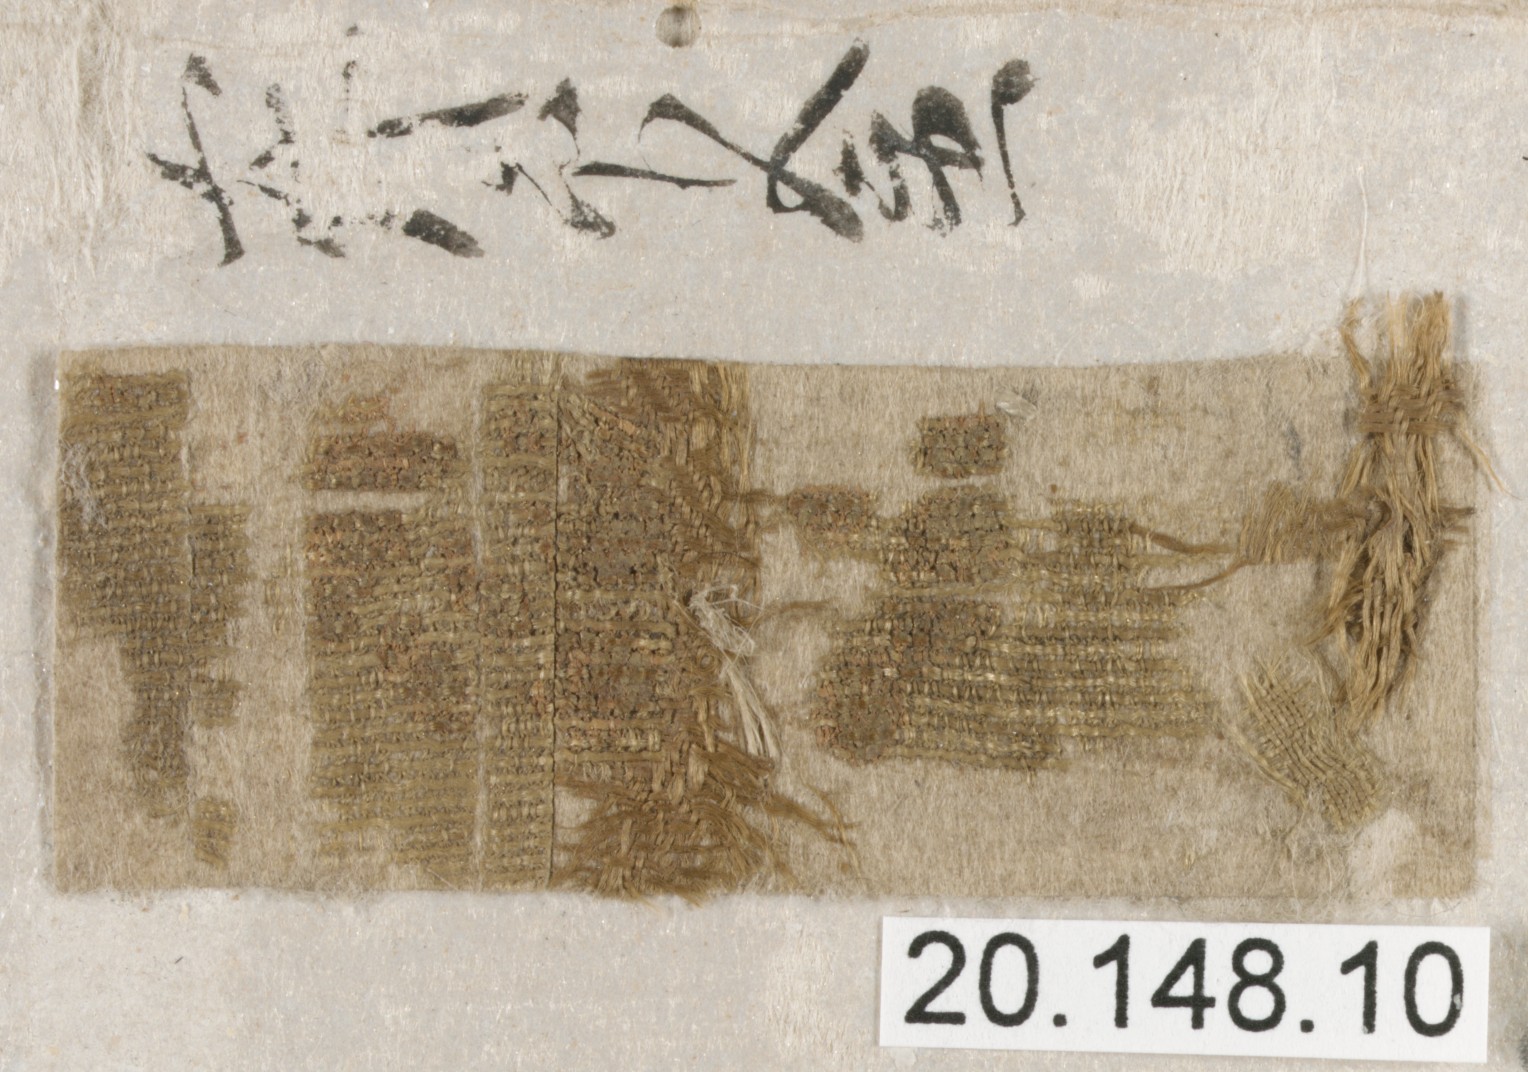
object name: piece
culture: japanese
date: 901-1000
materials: silk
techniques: compound weave